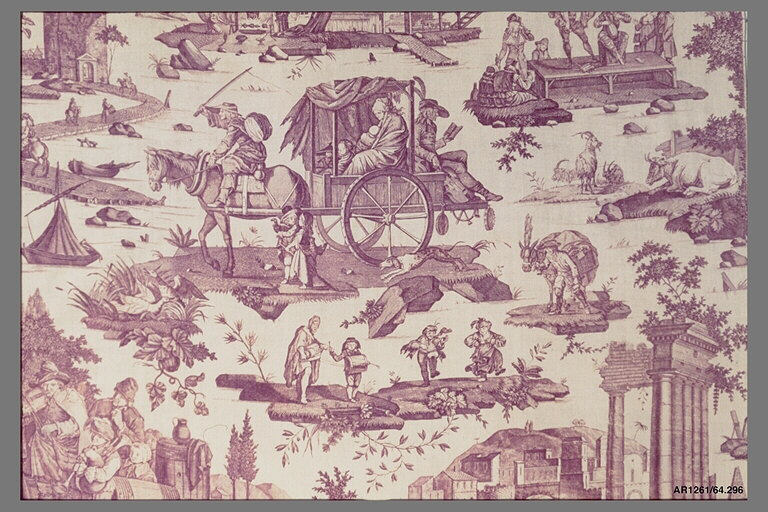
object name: piece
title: "Les Comédiens Ambulants"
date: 1795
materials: cotton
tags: human figures,animals,horses,boats,carriages